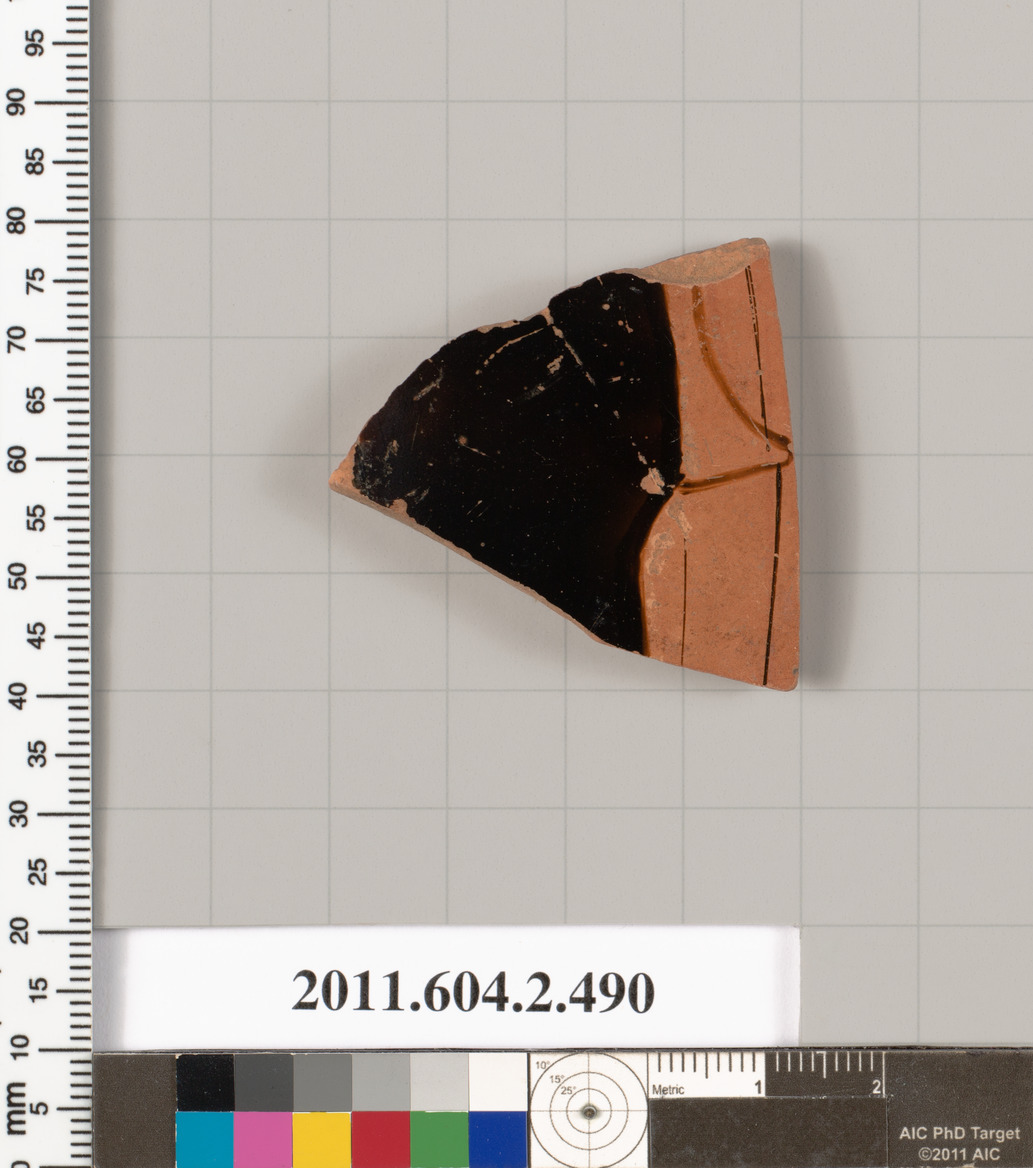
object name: column krater fragment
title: Terracotta fragment of a column-krater (bowl for mixing wine and water)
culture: greek, attic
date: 450-430 BCE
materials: terracotta